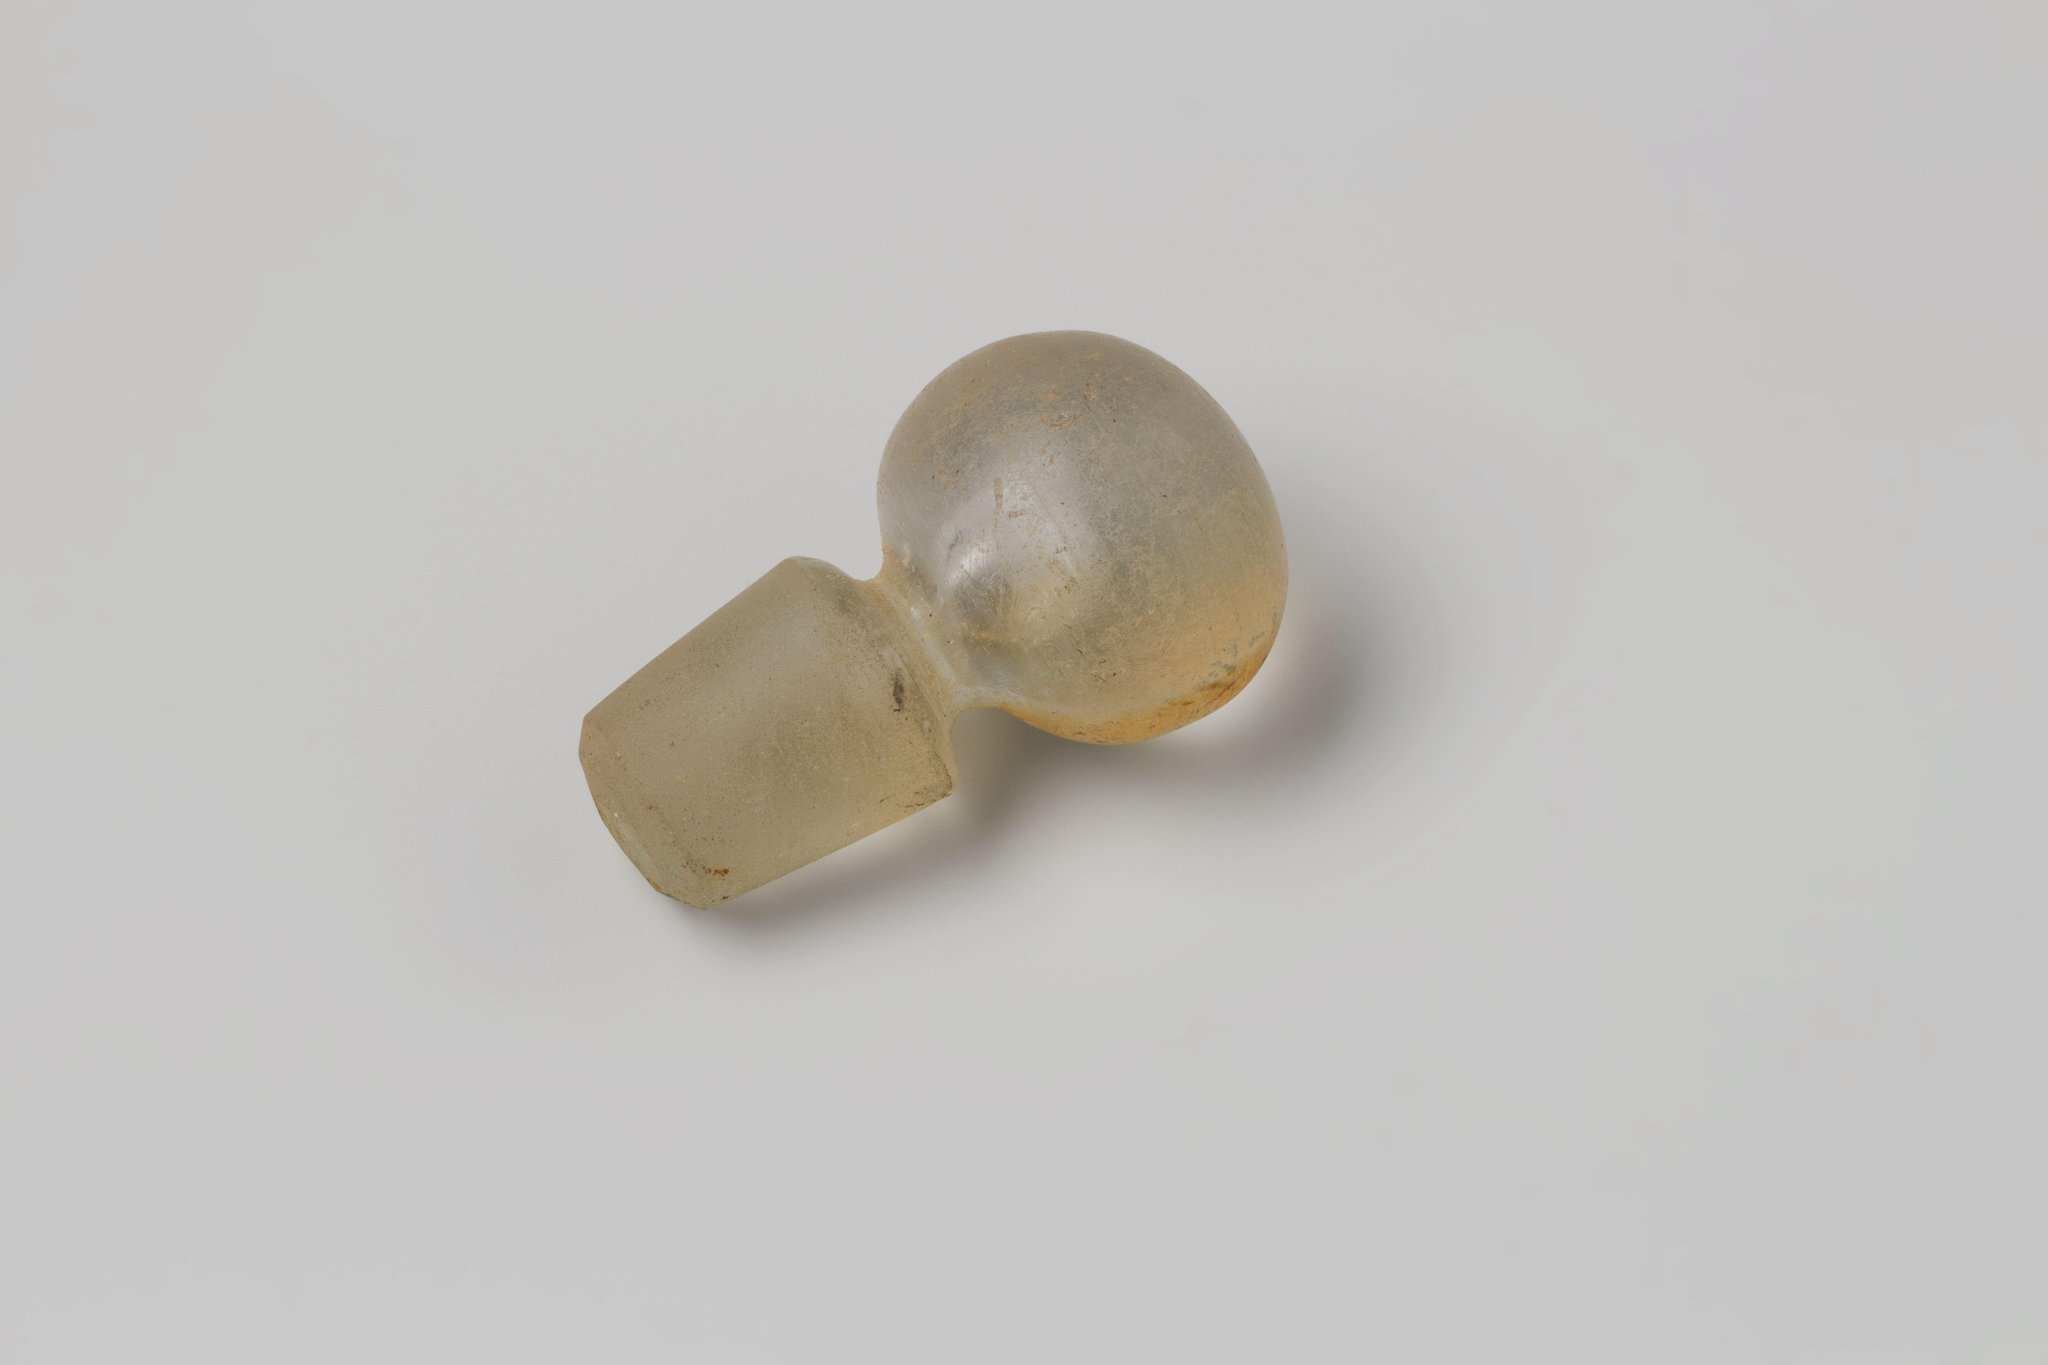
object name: bung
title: Stop van vaatwerk uit het wrak van de Oost-Indiëvaarder Hollandia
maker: Anonymous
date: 1700-1743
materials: glass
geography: netherlands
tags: verenigde oostindische compagnie, hollandia (schip), annet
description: Vessel part, stopper; tapering cylinder with spherical finial.